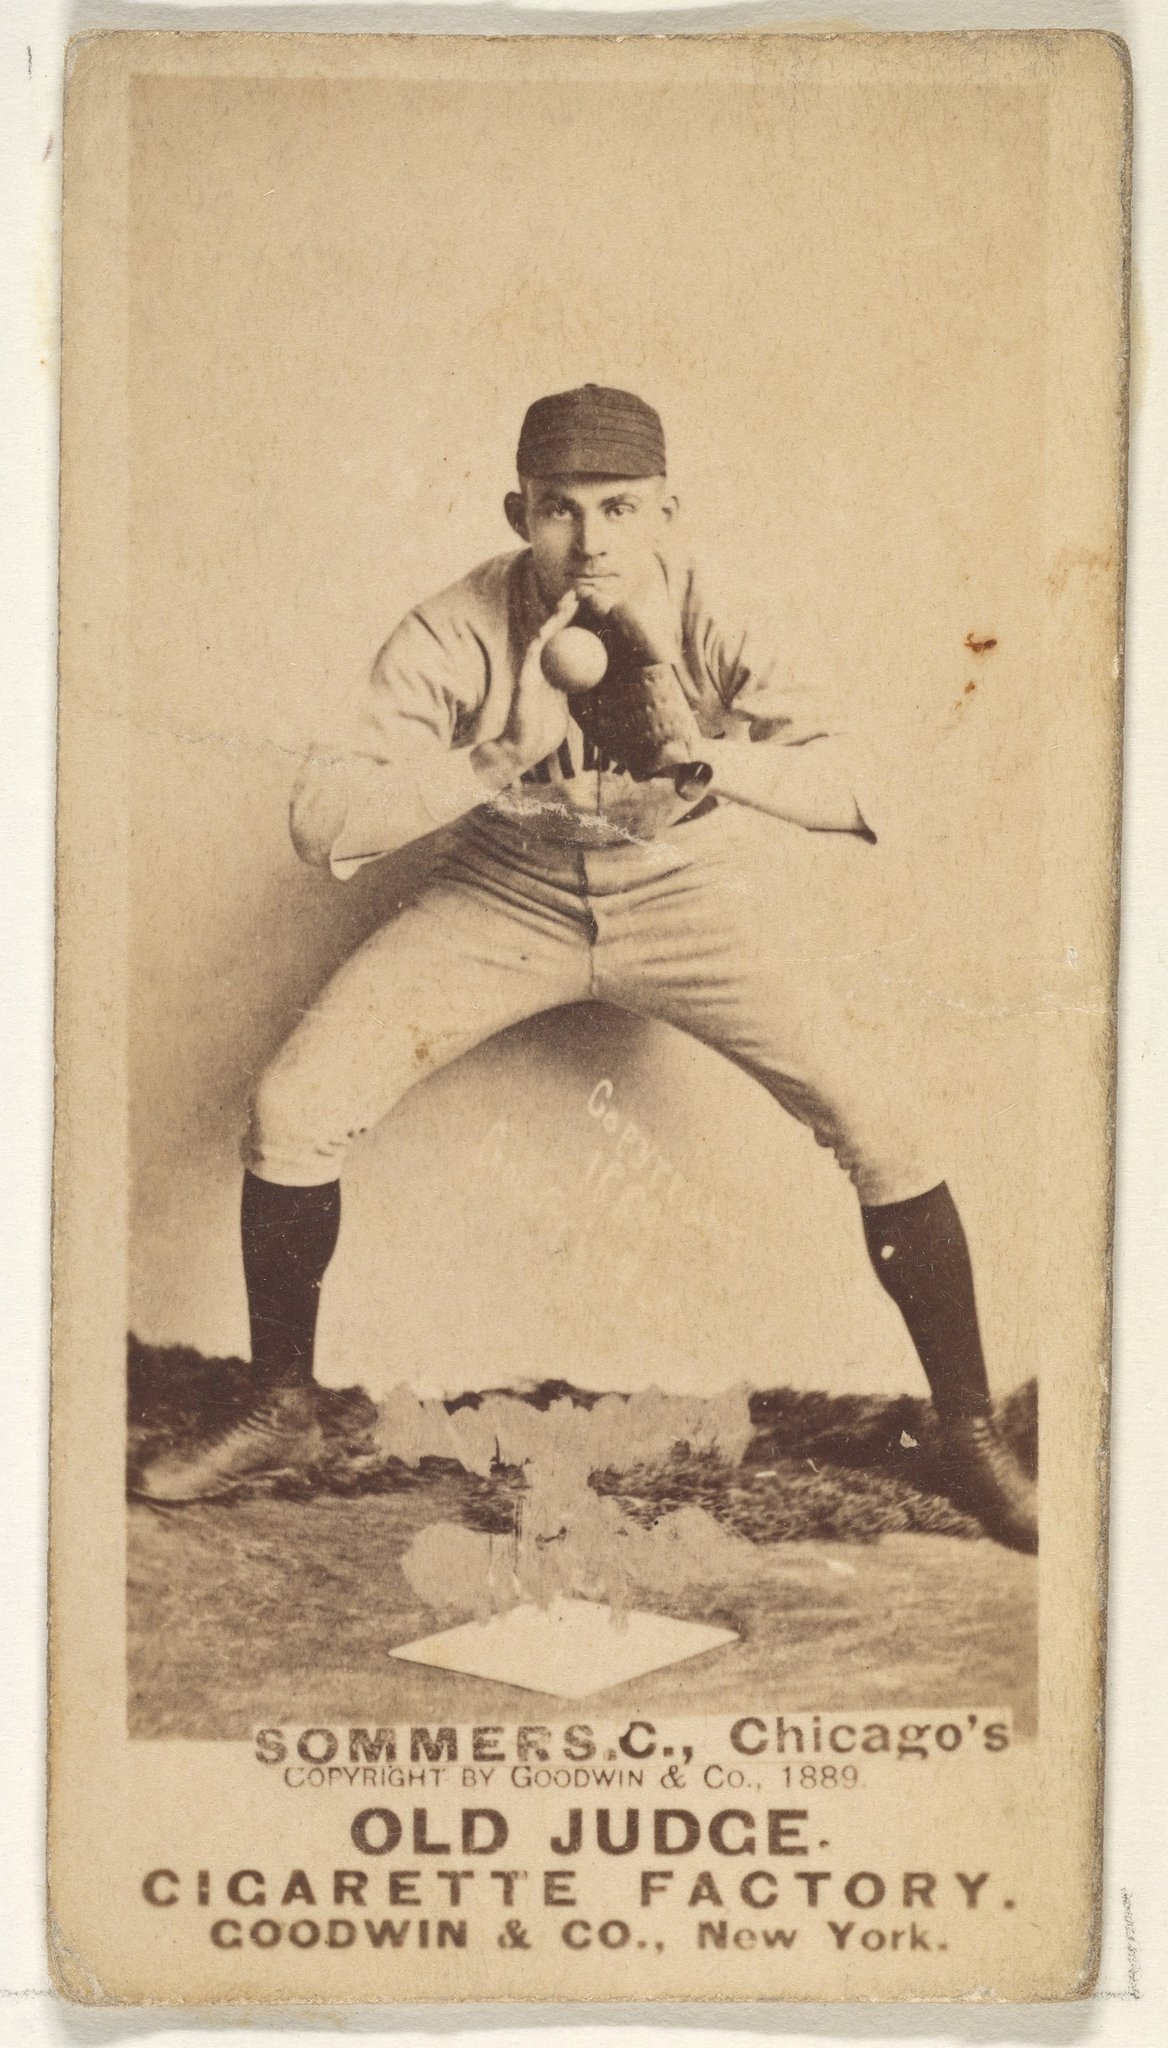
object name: baseball card, photograph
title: Sommers, Catcher, Chicago, from the Old Judge series (N172) for Old Judge Cigarettes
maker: goodwin & company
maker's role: publisher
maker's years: 1850-1950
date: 1889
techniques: albumen silver print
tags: men,portraits,baseball,athletes